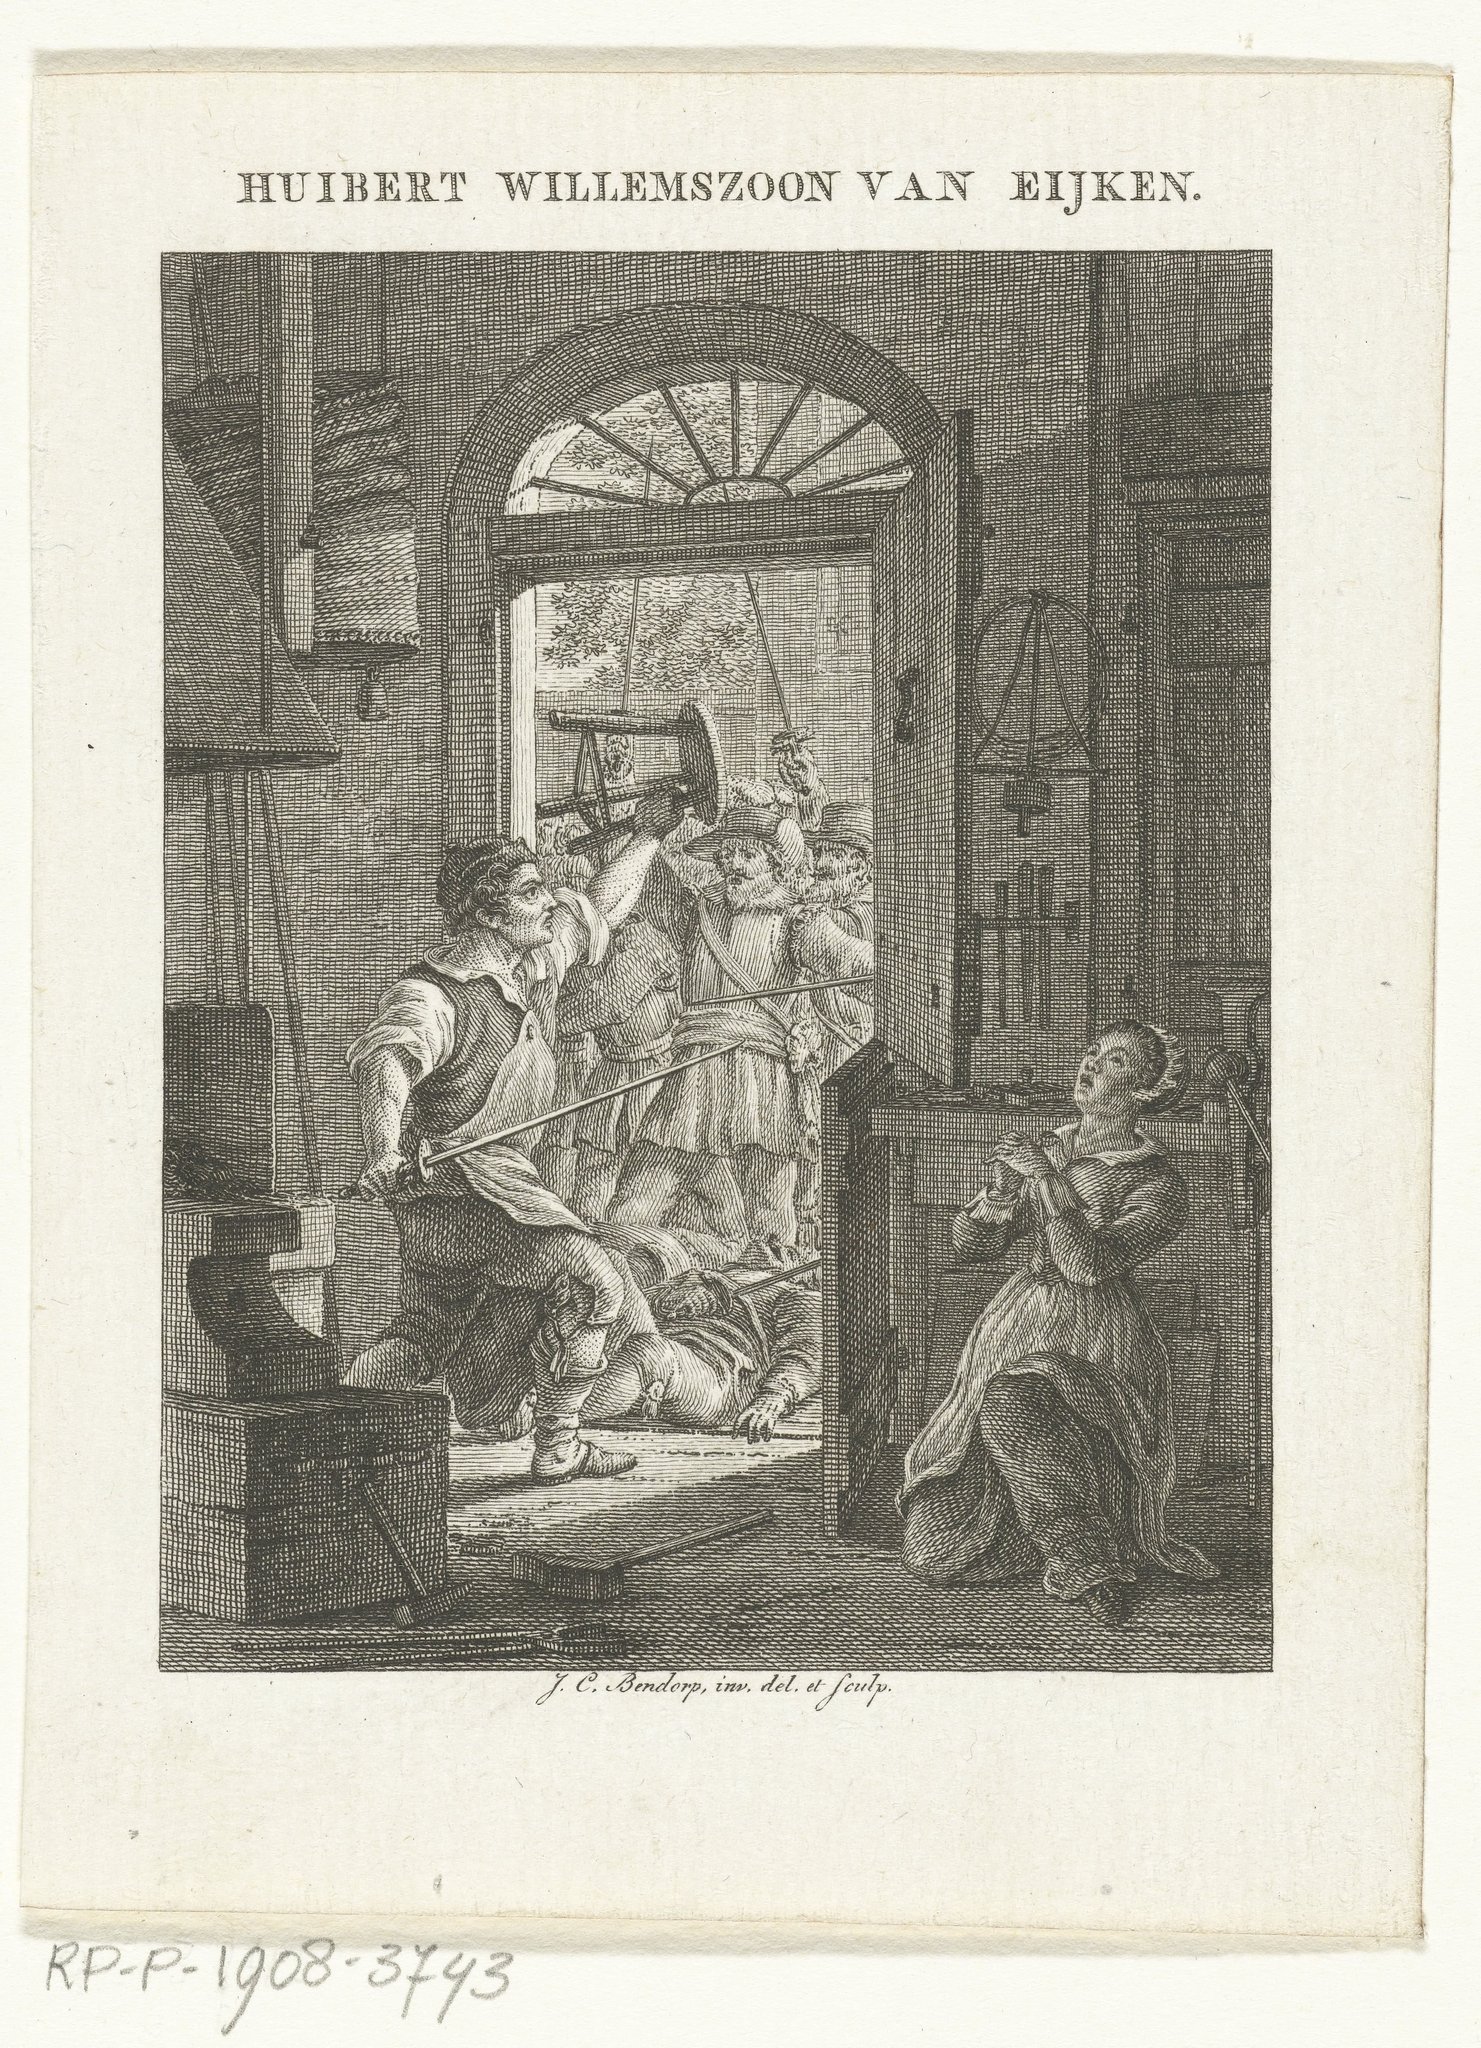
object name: print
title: Huibert Willemszoon van Eijken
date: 1776-1827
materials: paper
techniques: etching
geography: the hague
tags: smith, blacksmith, challenging the enemy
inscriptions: collector's mark: Lugt 2228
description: Prent uit: Nederlandsche muzen-almanak, Johannes Immerzeel (uitgever), Den Haag 1827. Voor het verhaal over de moedige smid zie: Wagenaar, Jan, Vaderlandsche historie: vervattend de geschiedenissen der nu Vereenigde Nederlanden, inzonderheid die van Holland, van de vroegste tyden af: Uit de geloofwaardigste schryvers en egte gedenkstukken samengesteld. Met konstplaaten en daarten opgehelderd ... Isaac Tirion (uitgever), Amsterdam 1752.